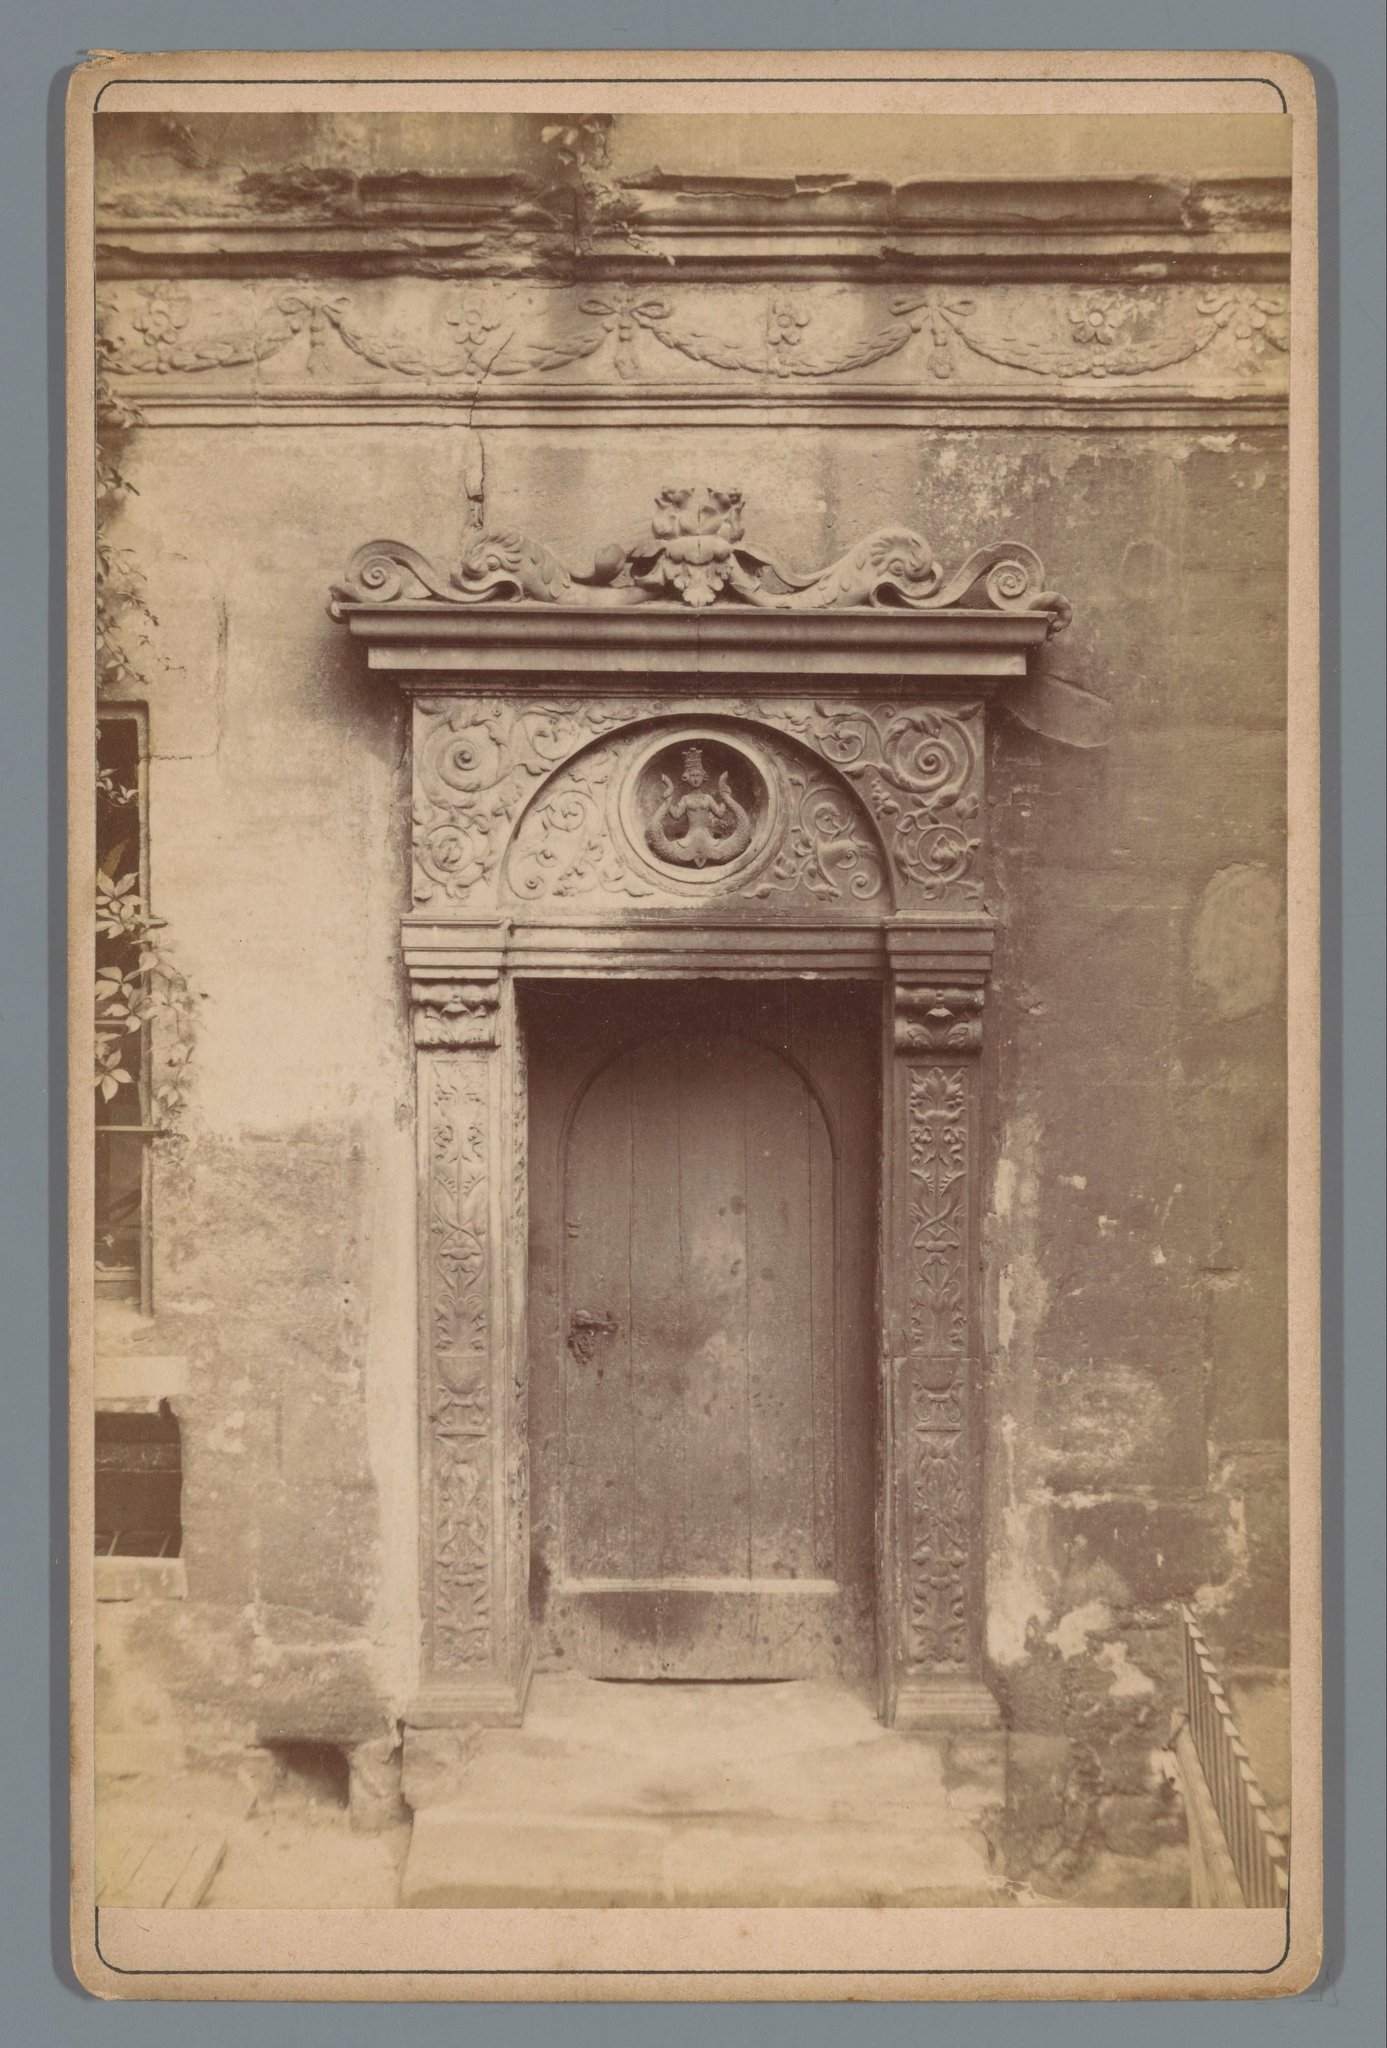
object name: cabinet photograph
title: Ingang van de Hirschvogelsaal in Neurenberg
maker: Anonymous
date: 1850-1900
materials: cardboard, photographic support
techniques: albumen print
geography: nuremberg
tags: gate, entrance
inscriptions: annotation: ‘Thür im Gartenhaus/ vom Hirschvogelhaus/ i.d. Hirschelgasse zu/ Nürnberg.’